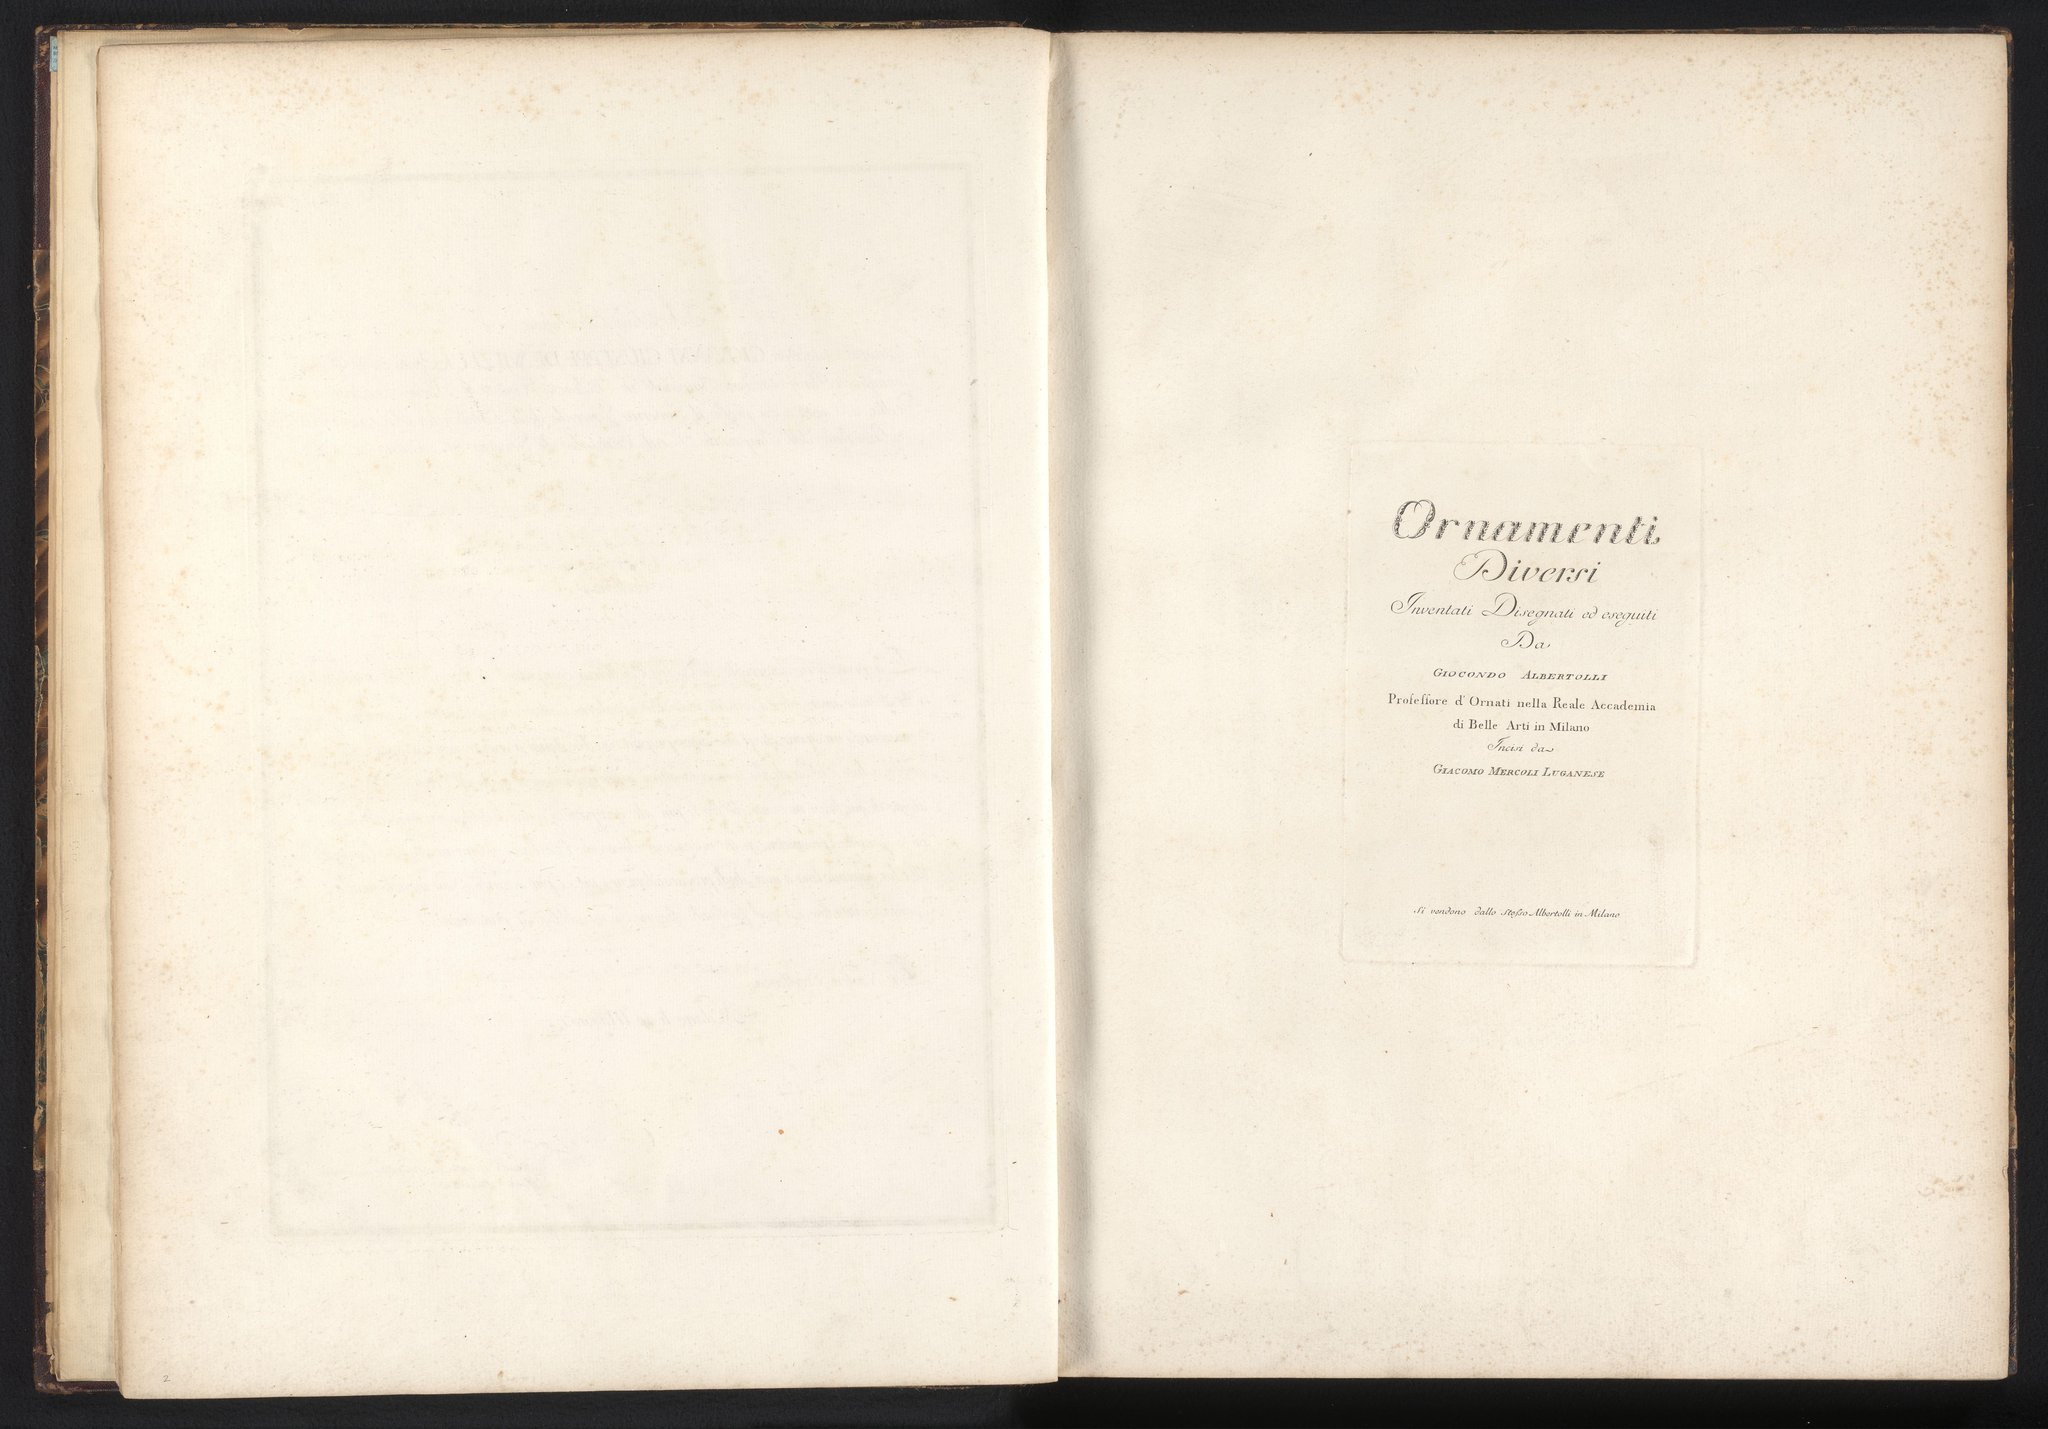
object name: prentrecueil, prentenalbum, prentalbum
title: Album met twee series ornamentprenten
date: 1787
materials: paper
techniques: engraving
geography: milan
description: Album met twee series ornamentprenten naar Giocondo Albertolli. Voorin het album achtereenvolgens de twee titelbladen en de twee opdrachten voor de series uit 1787 (aan Giovanni Giuseppe de Wilzeck) en 1782 (aan Giuseppe Piermarini) gevolgd door een bericht 'L'Autore a chi Legge' (aan de lezer) uit 1782. Hierna volgen aaneengesloten de serie 'Alcune Decorazioni di Nobili Sale ed Altri Ornamenti' uit 1787 bestaande uit 22 platen genummerd I-XXII door Giacomo Mercoli en Andrea de Bernardis. Aan deze serie is een extra plaat toegevoegd, genummerd XXIII en gedateerd 1788. Hierna volgt de serie 'Ornamenti Diversi' uit 1782 bestaande uit 24 platen genummerd I-XXIV door Giacomo Mercoli, Michelangelo Mercoli en Domenico Aspari. Gebonden in eigentijdse band.